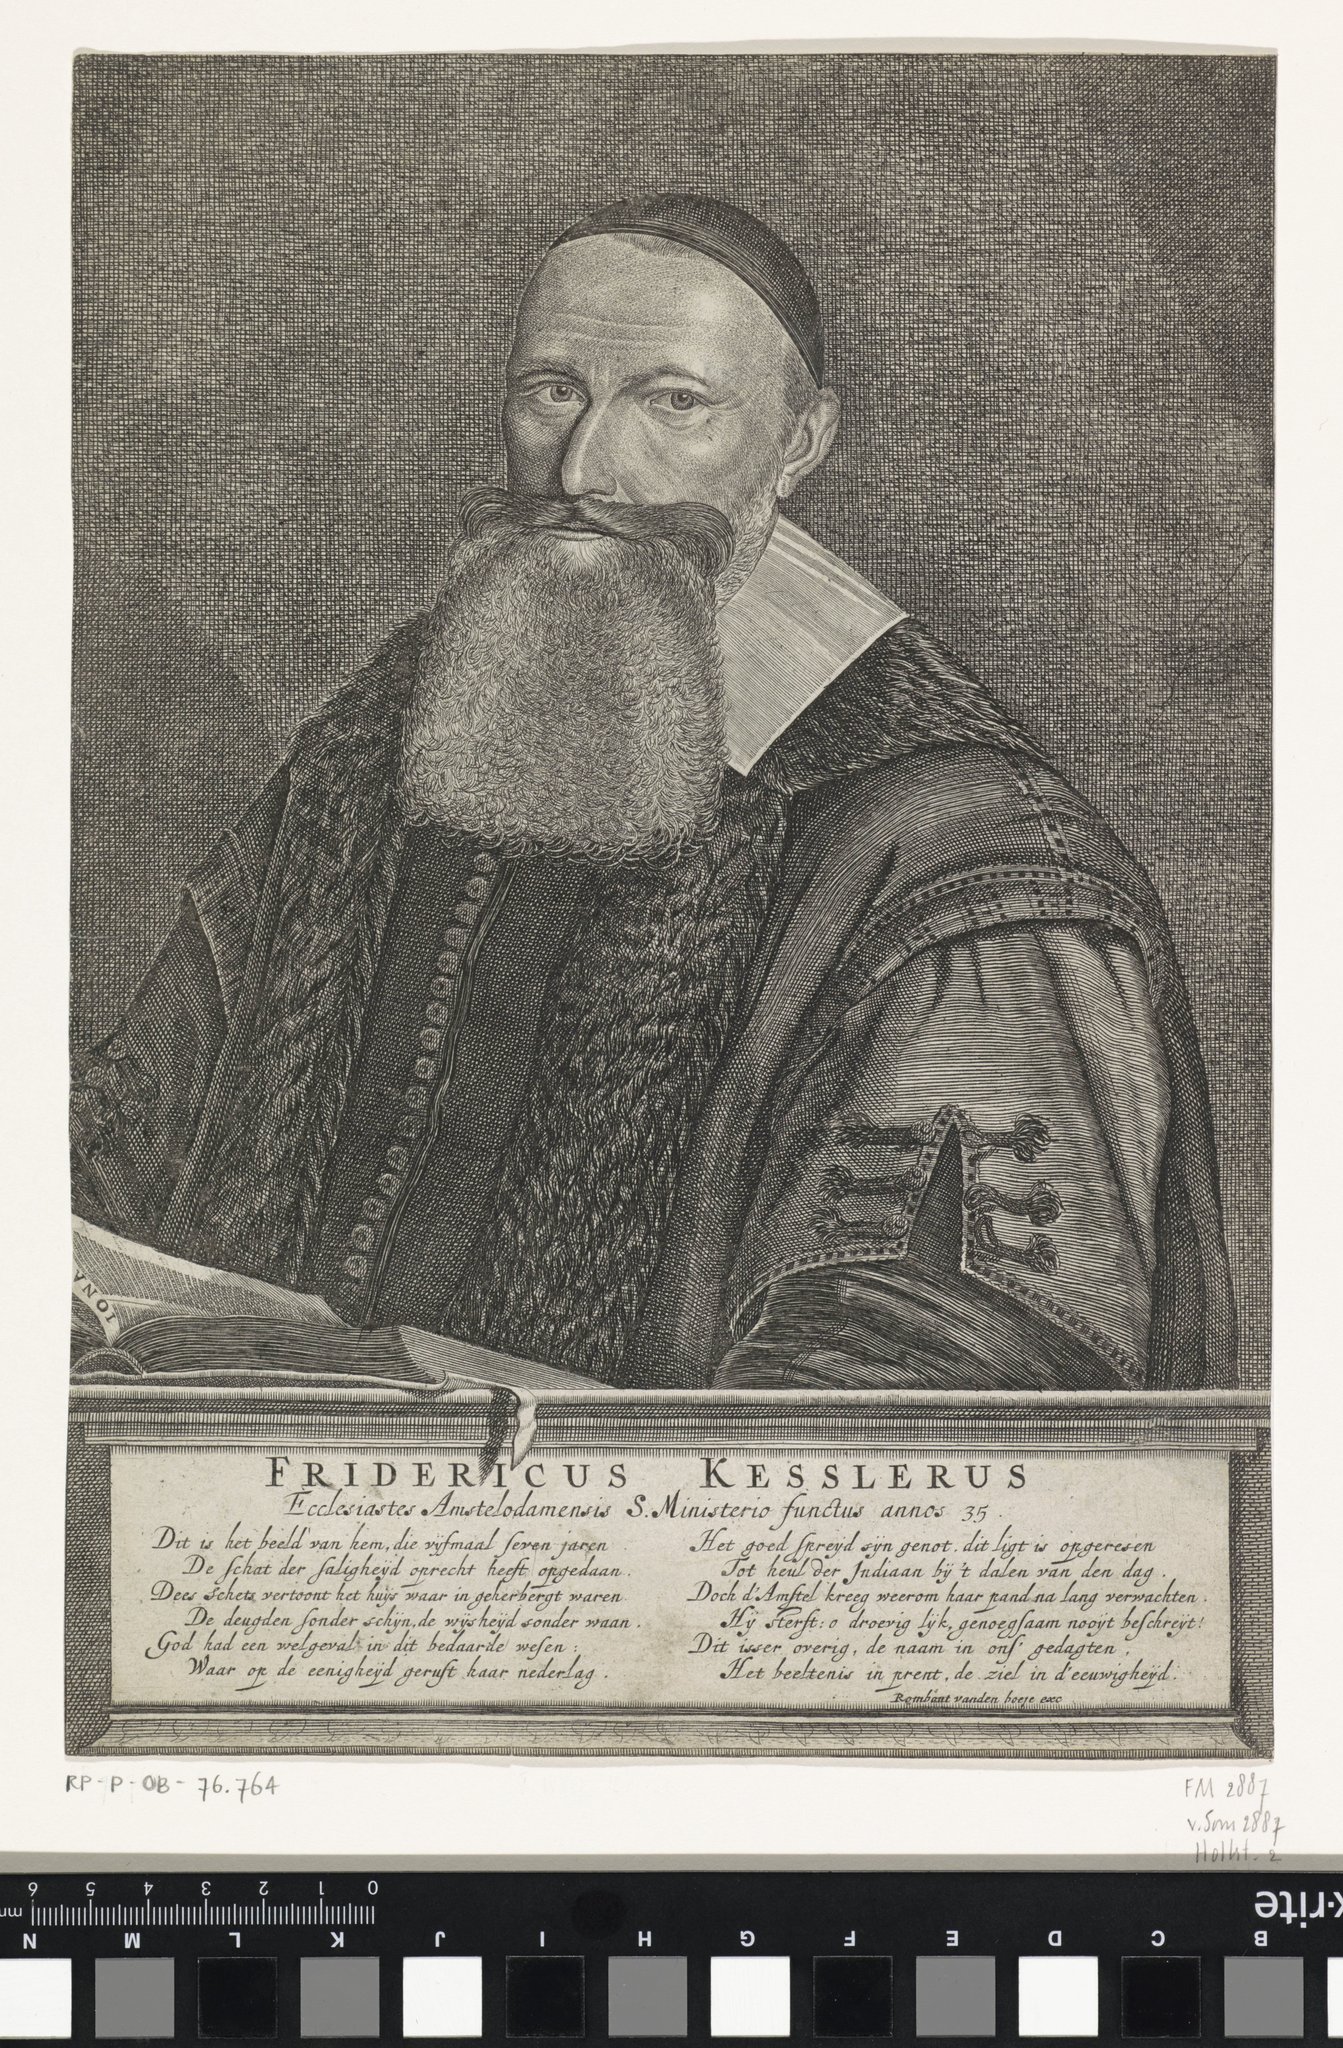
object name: print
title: Portret van Frederik Kessler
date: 1650-1660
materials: paper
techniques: engraving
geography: amsterdam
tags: historical persons, the bible as a book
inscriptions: collector's mark: Lugt 2228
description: Portret van de predikant Frederik Kessler met een opengeslagen bijbel. Onder de naam van de geportretteerde staat zijn functie en wordt vermeld dat hij 35 jaar actief was. Daaronder een tienregelig lofdicht ter ere van de geportretteerde in het Nederlands.